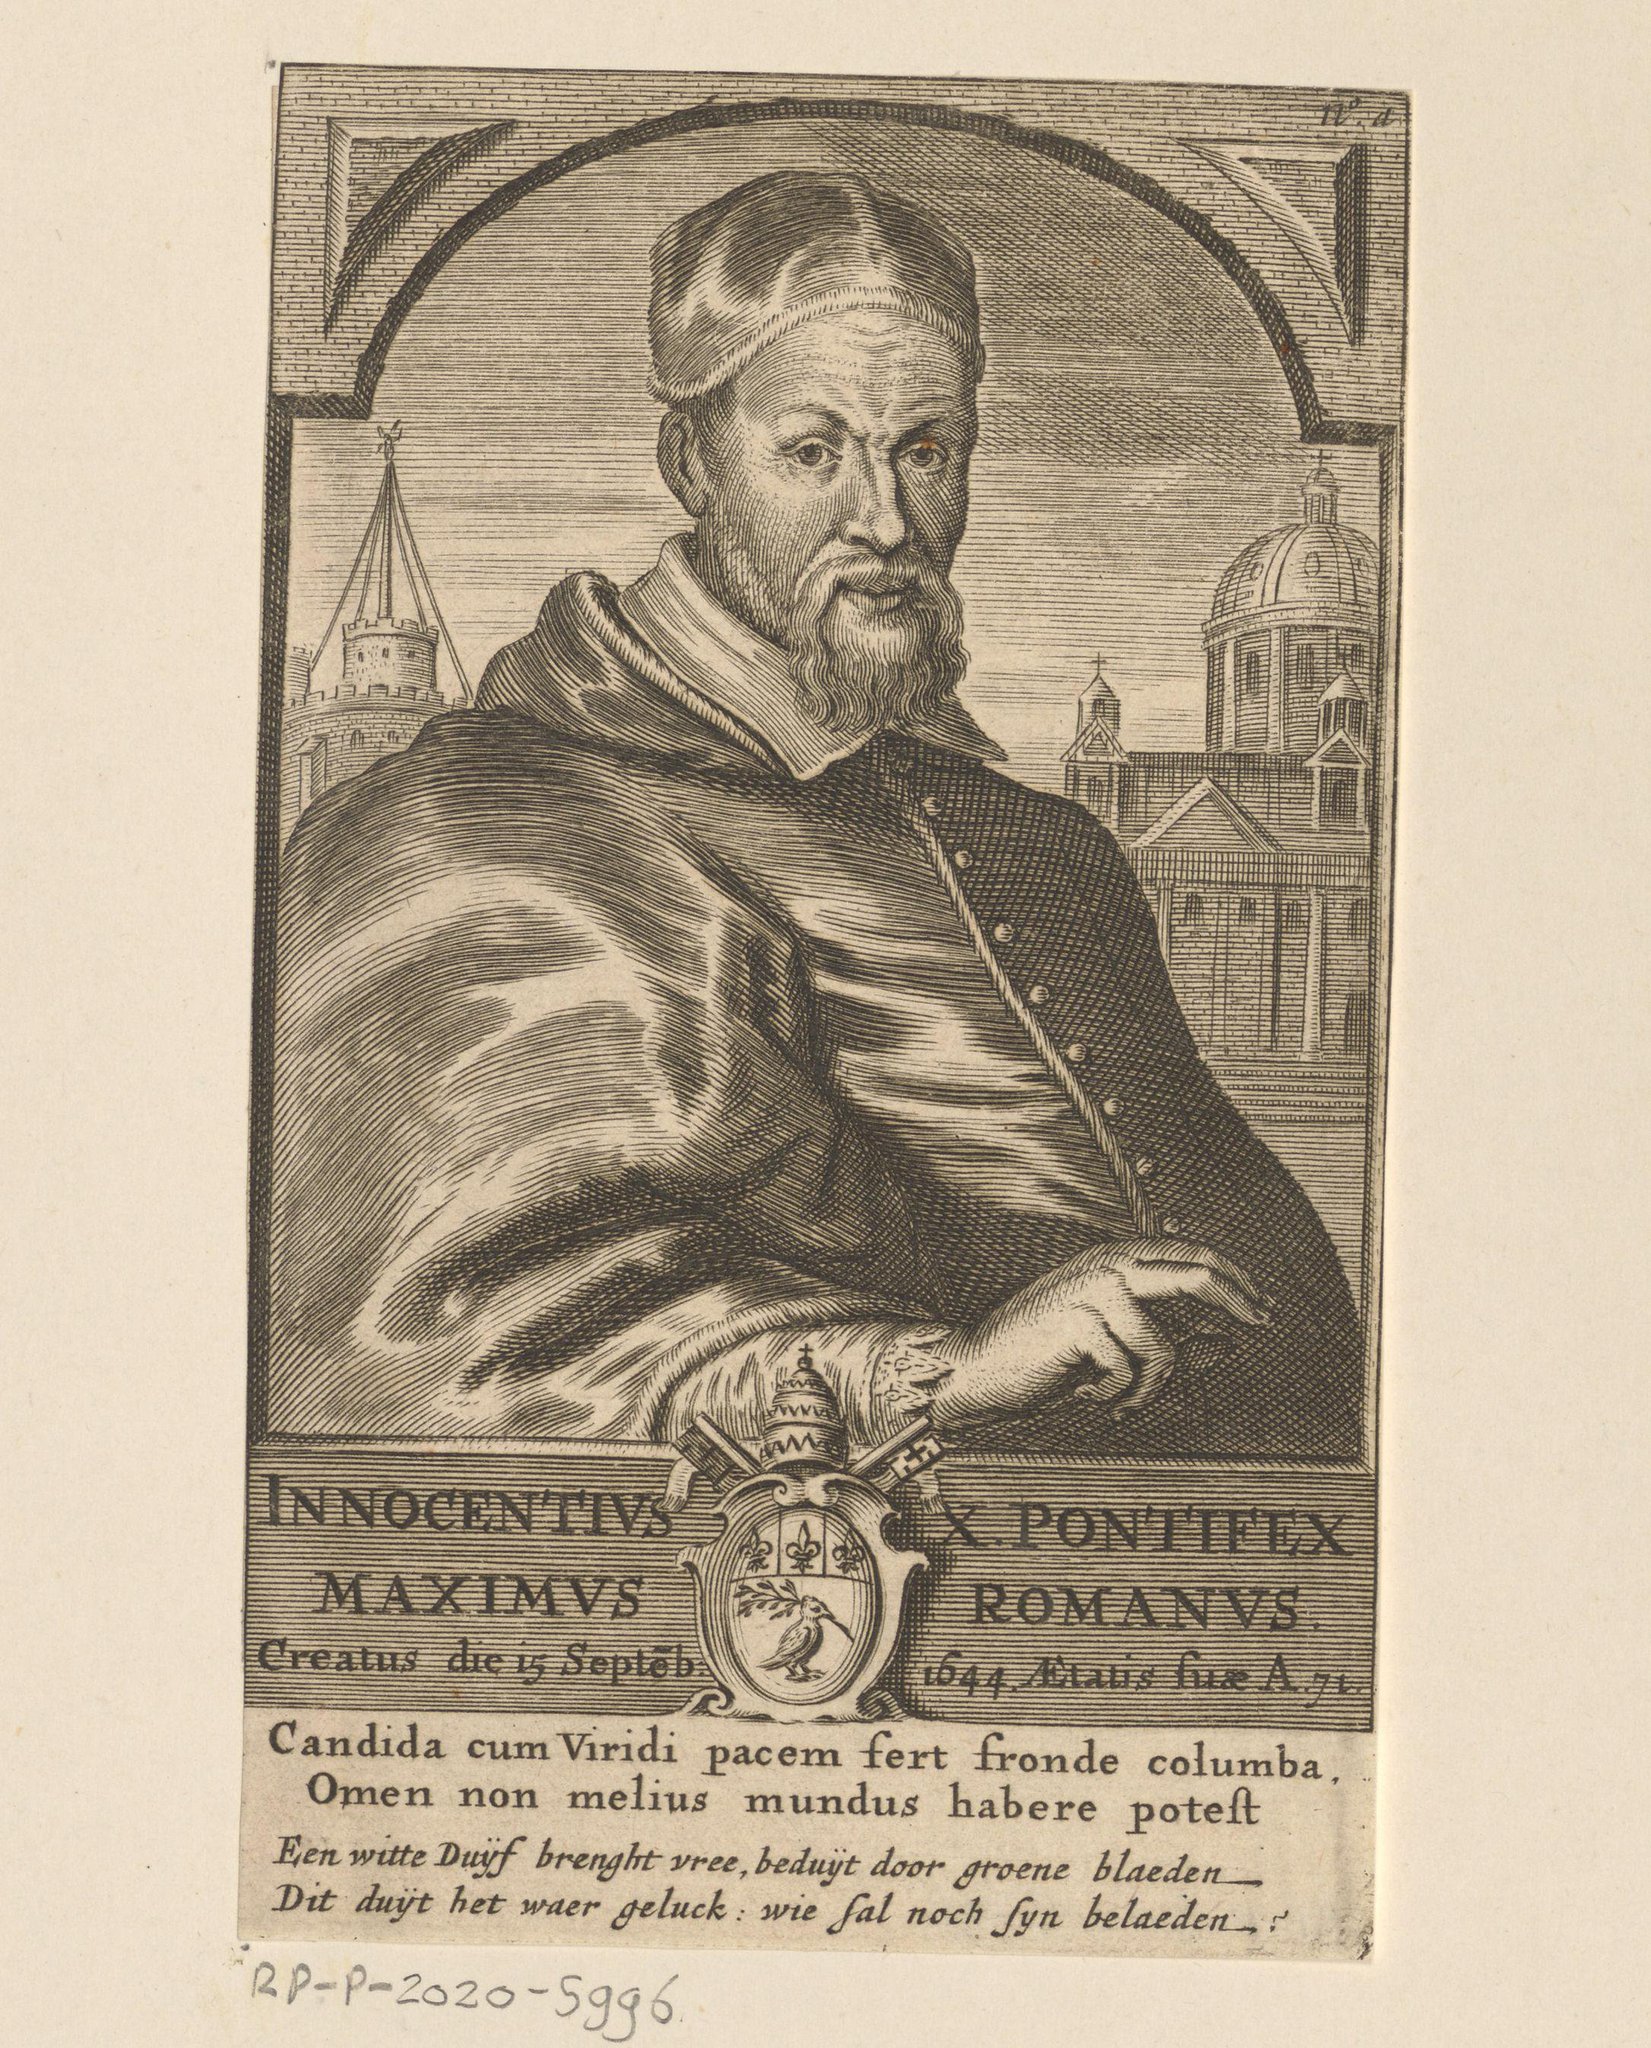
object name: print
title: Portret van paus Innocentius X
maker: Anonymous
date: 1644-1699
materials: paper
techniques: engraving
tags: innocentius x, hierarchy of jurisdiction ~ roman catholic church, historical persons, church (exterior), armorial bearing, heraldry